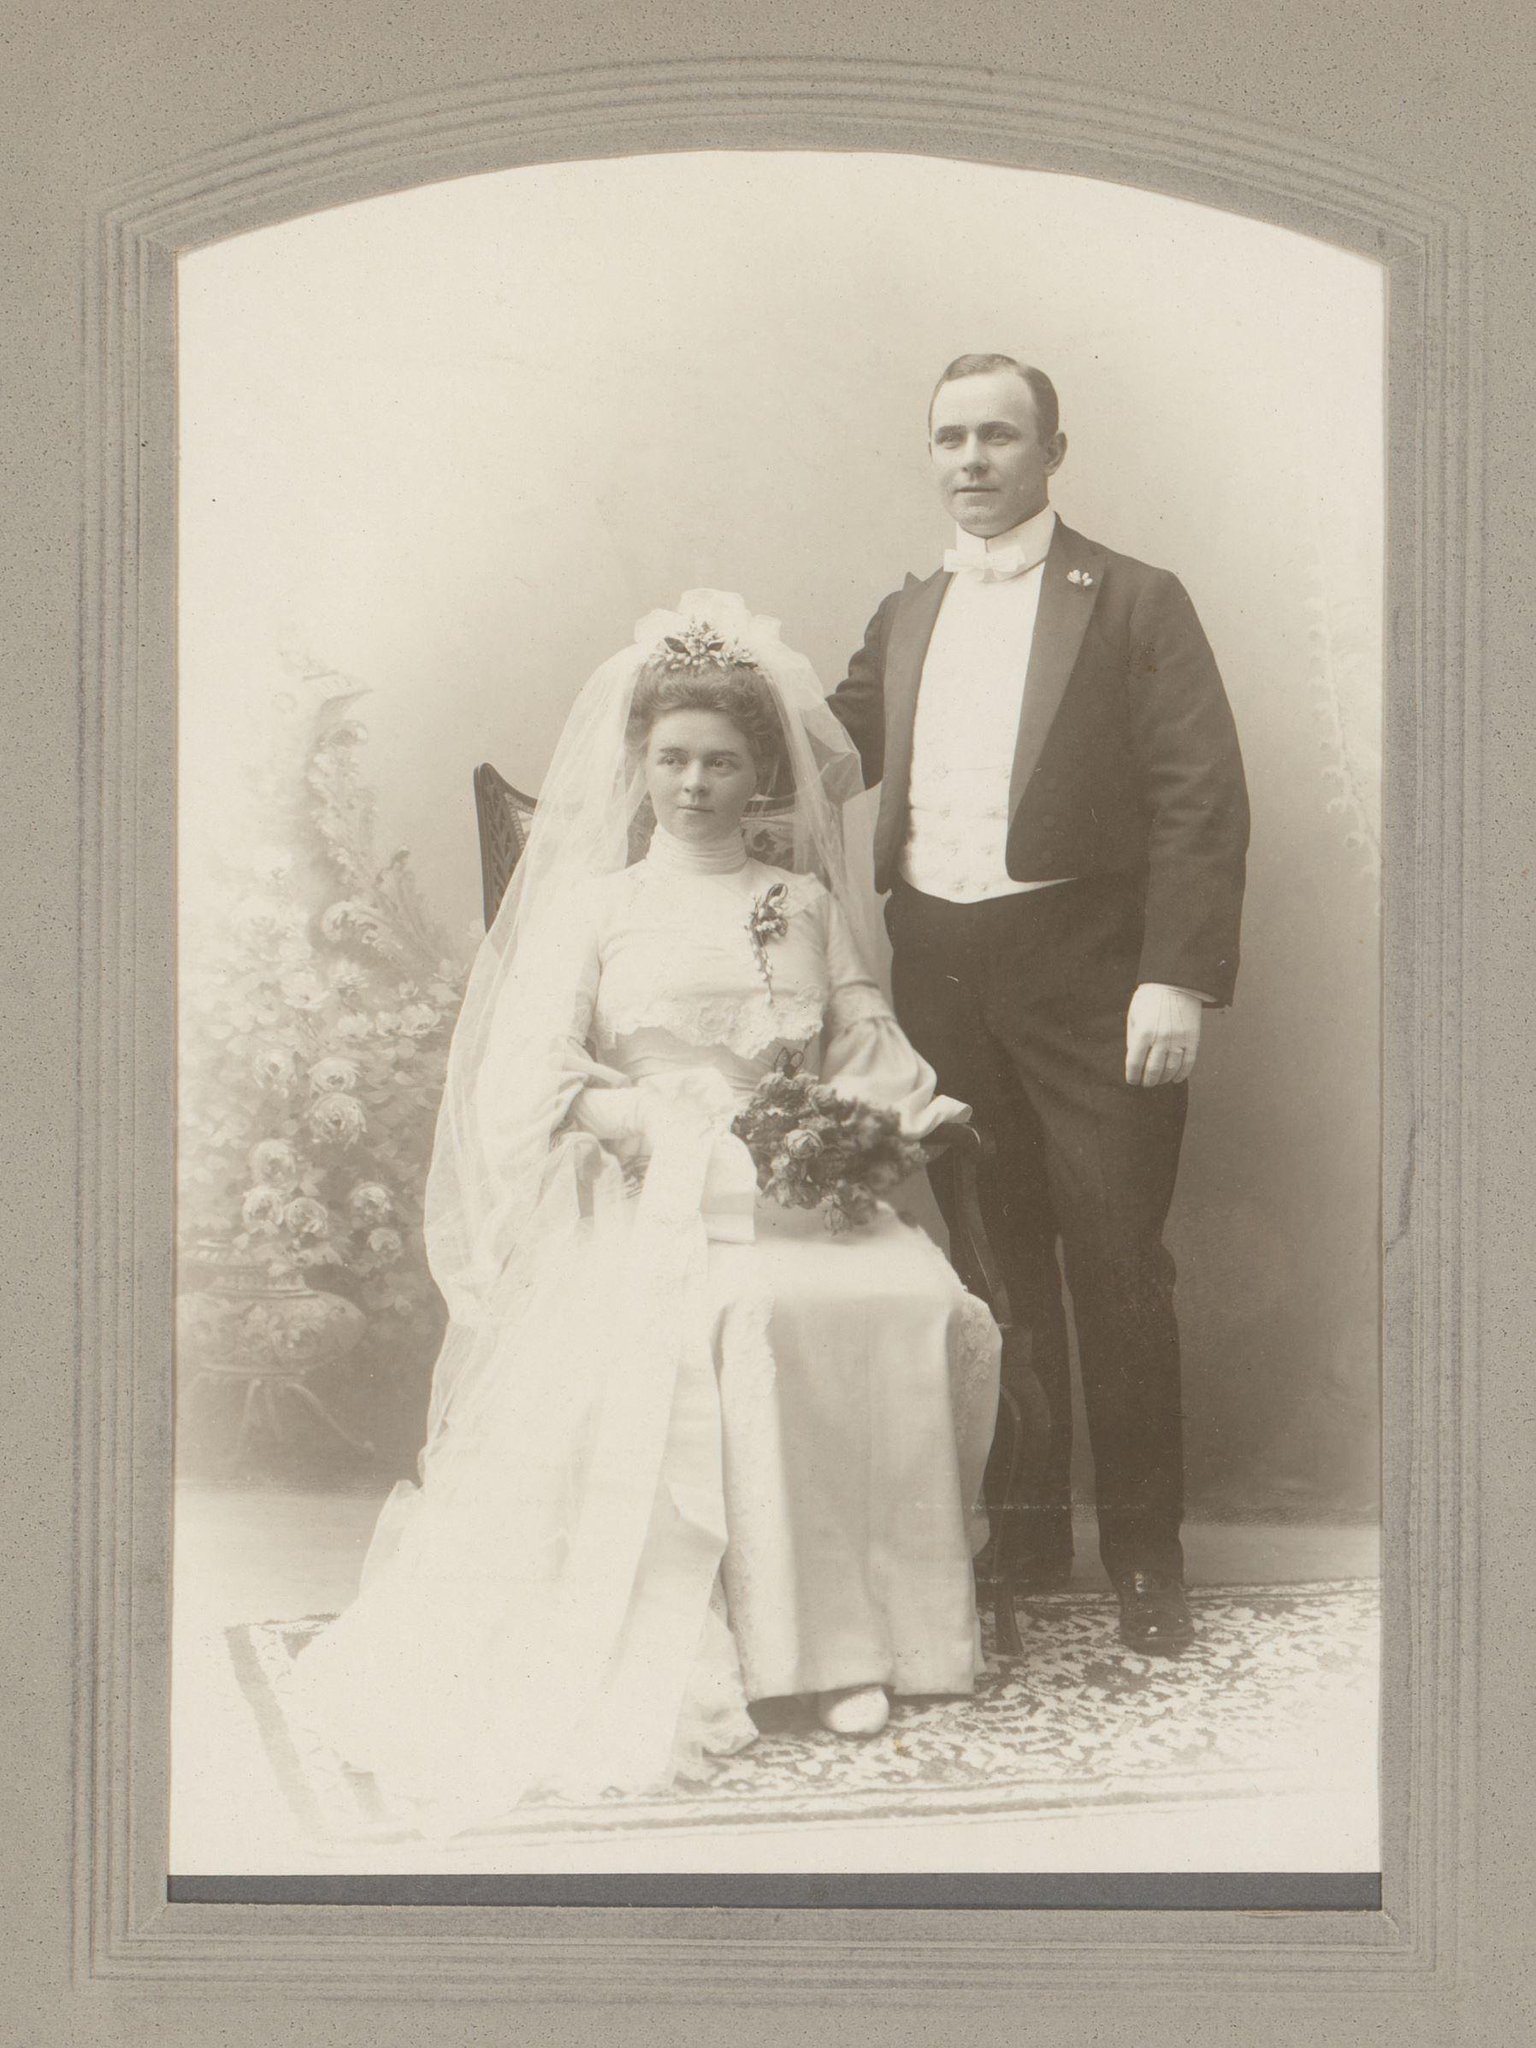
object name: cabinet photograph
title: Portret van een echtpaar in bruidskleding, de vrouw zittend en de man staand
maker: Anonymous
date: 1895-1920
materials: cardboard, photographic support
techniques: matte daylight collodion silver print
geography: sweden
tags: standing figure, sitting figure - aa - female human figure, bride and groom in wedding-dress, marriage, married couple, 'matrimonium'